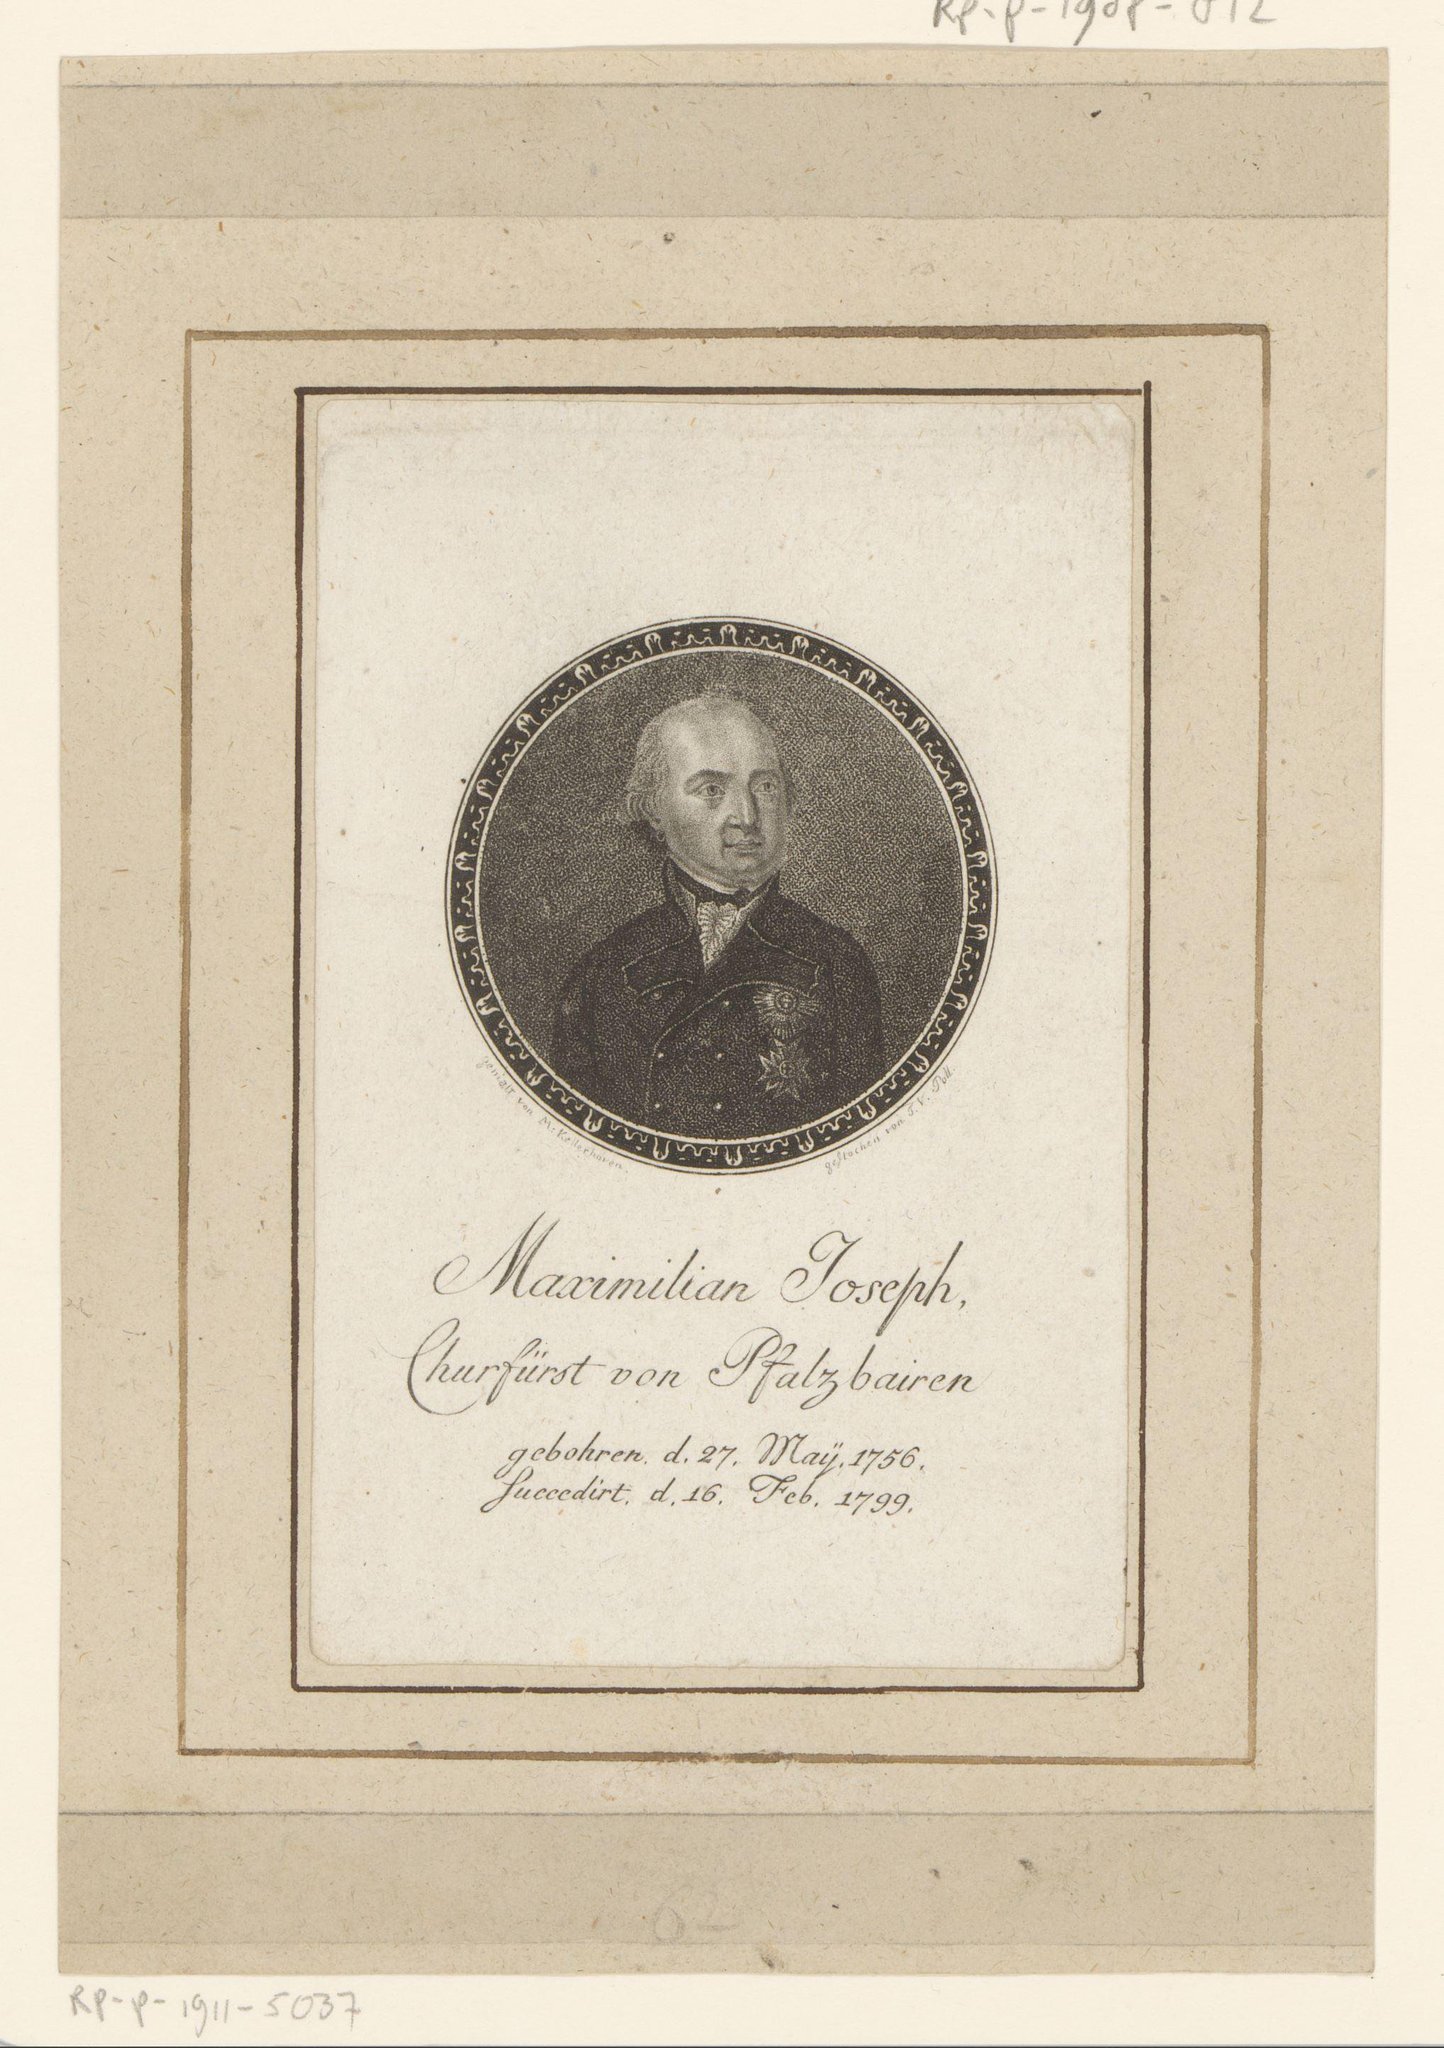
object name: print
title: Portret van Maximiliaan I Jozef, koning van Beieren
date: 1780-1880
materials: paper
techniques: engraving, etching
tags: maximiliaan i jozef (koning van beieren), historical persons, medals and other marks of military honour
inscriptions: collector's mark: Lugt 2228